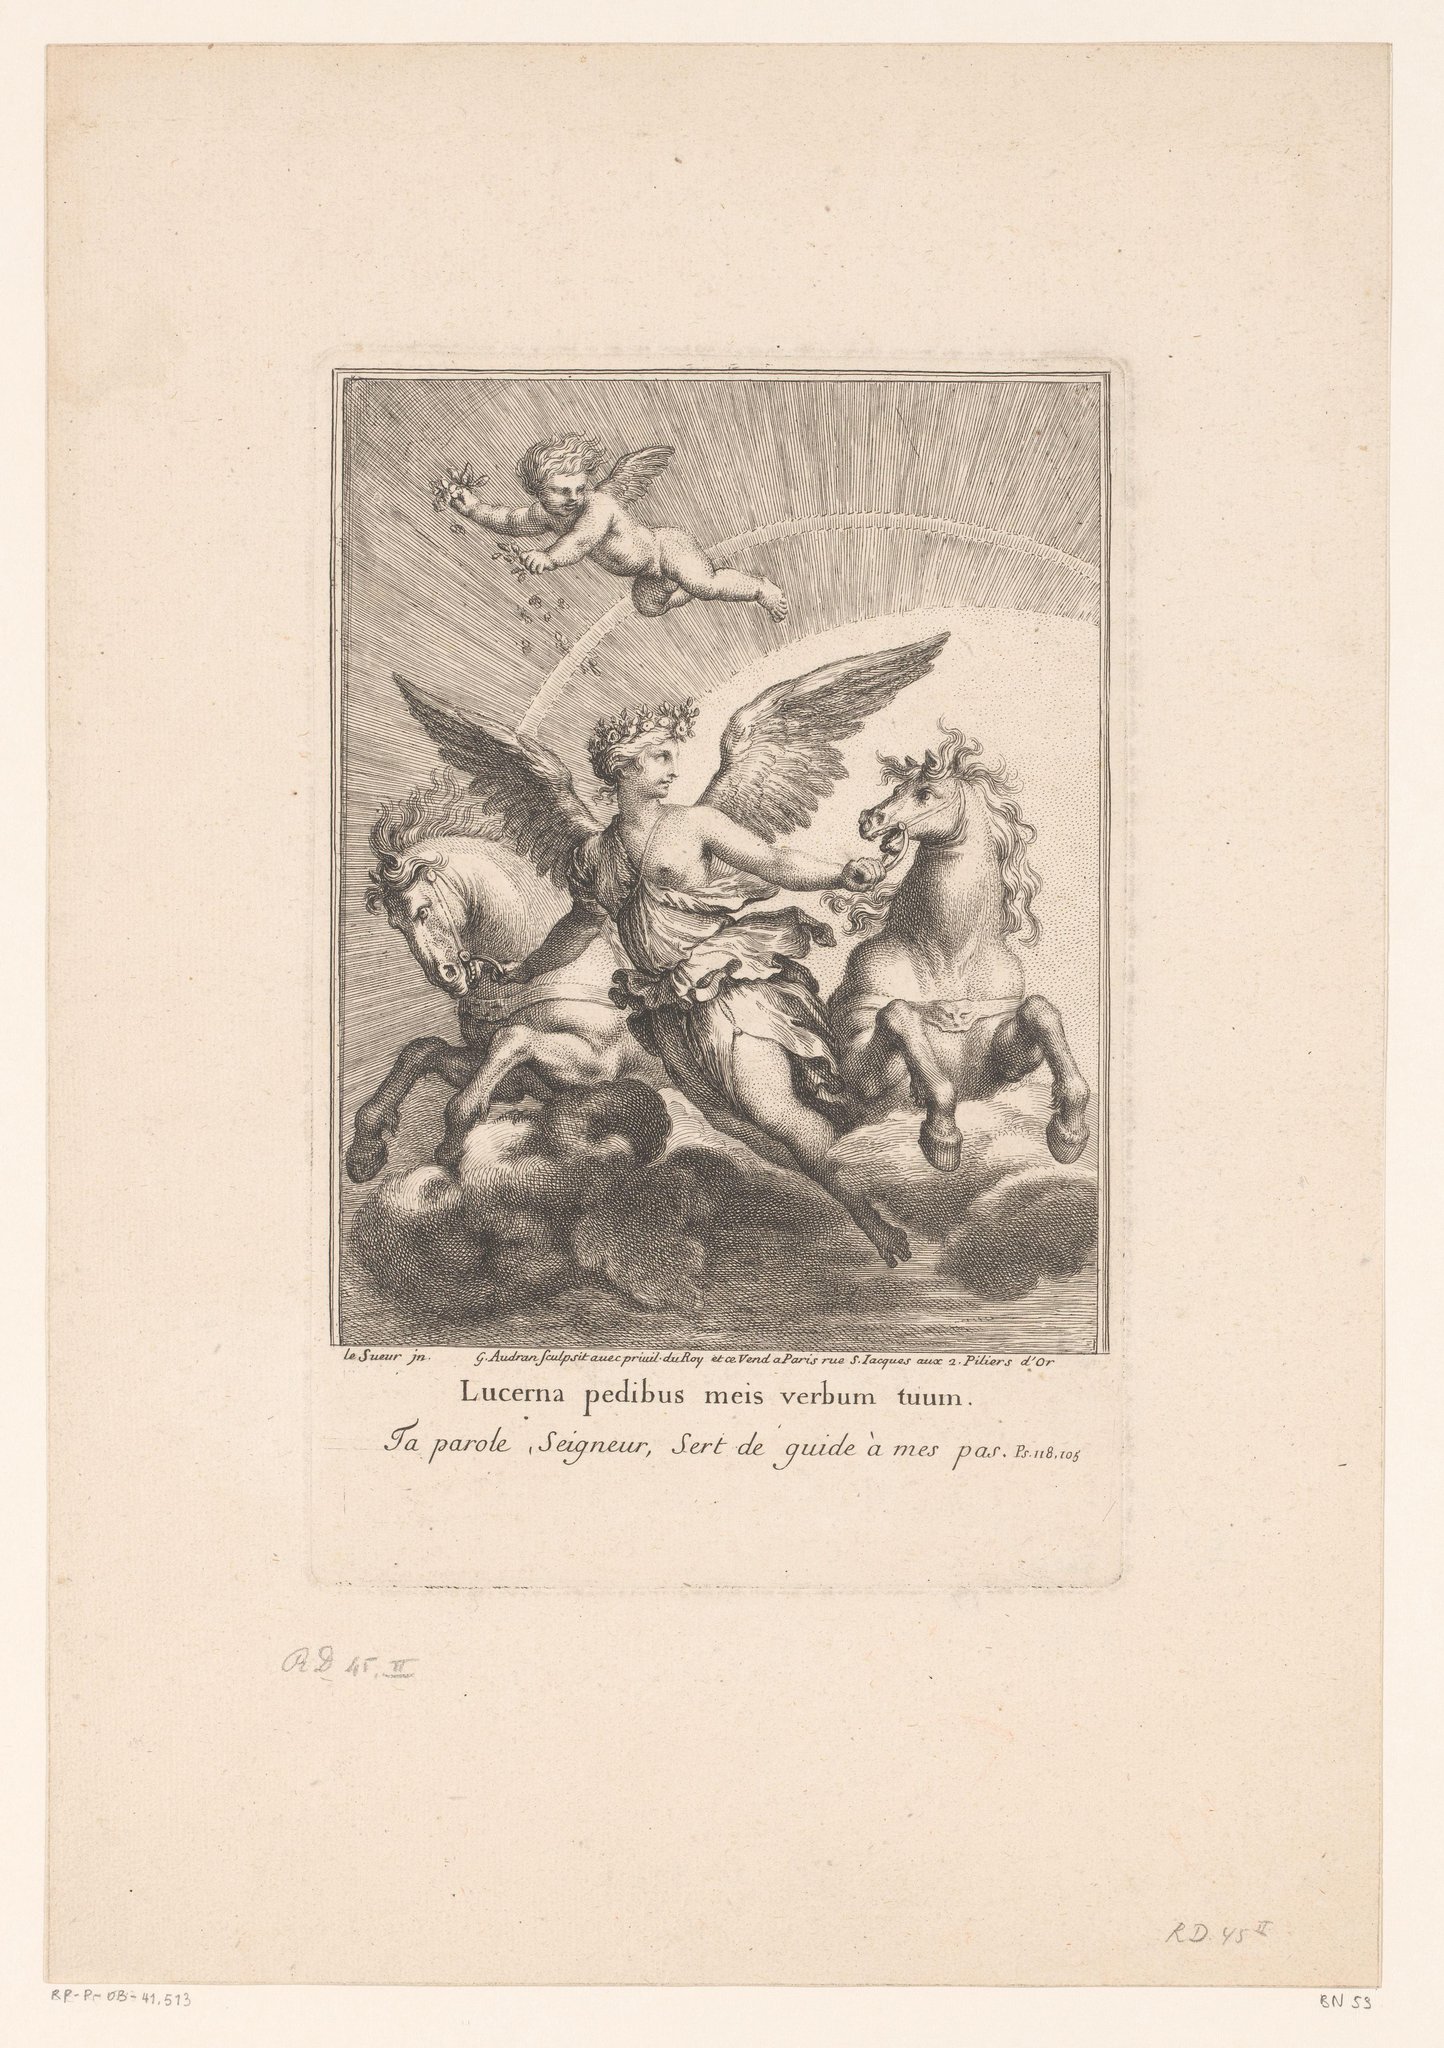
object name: print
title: Lucerna pedibus meis verbum tuum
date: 1650-1703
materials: paper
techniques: etching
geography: france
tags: triumph of aurora: in her chariot drawn by two (sometimes four) horses, and possibly scattering flowers; aurora's victory over the night; 'carro dell'aurora' (ripa)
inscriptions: collector's mark: Lugt 240